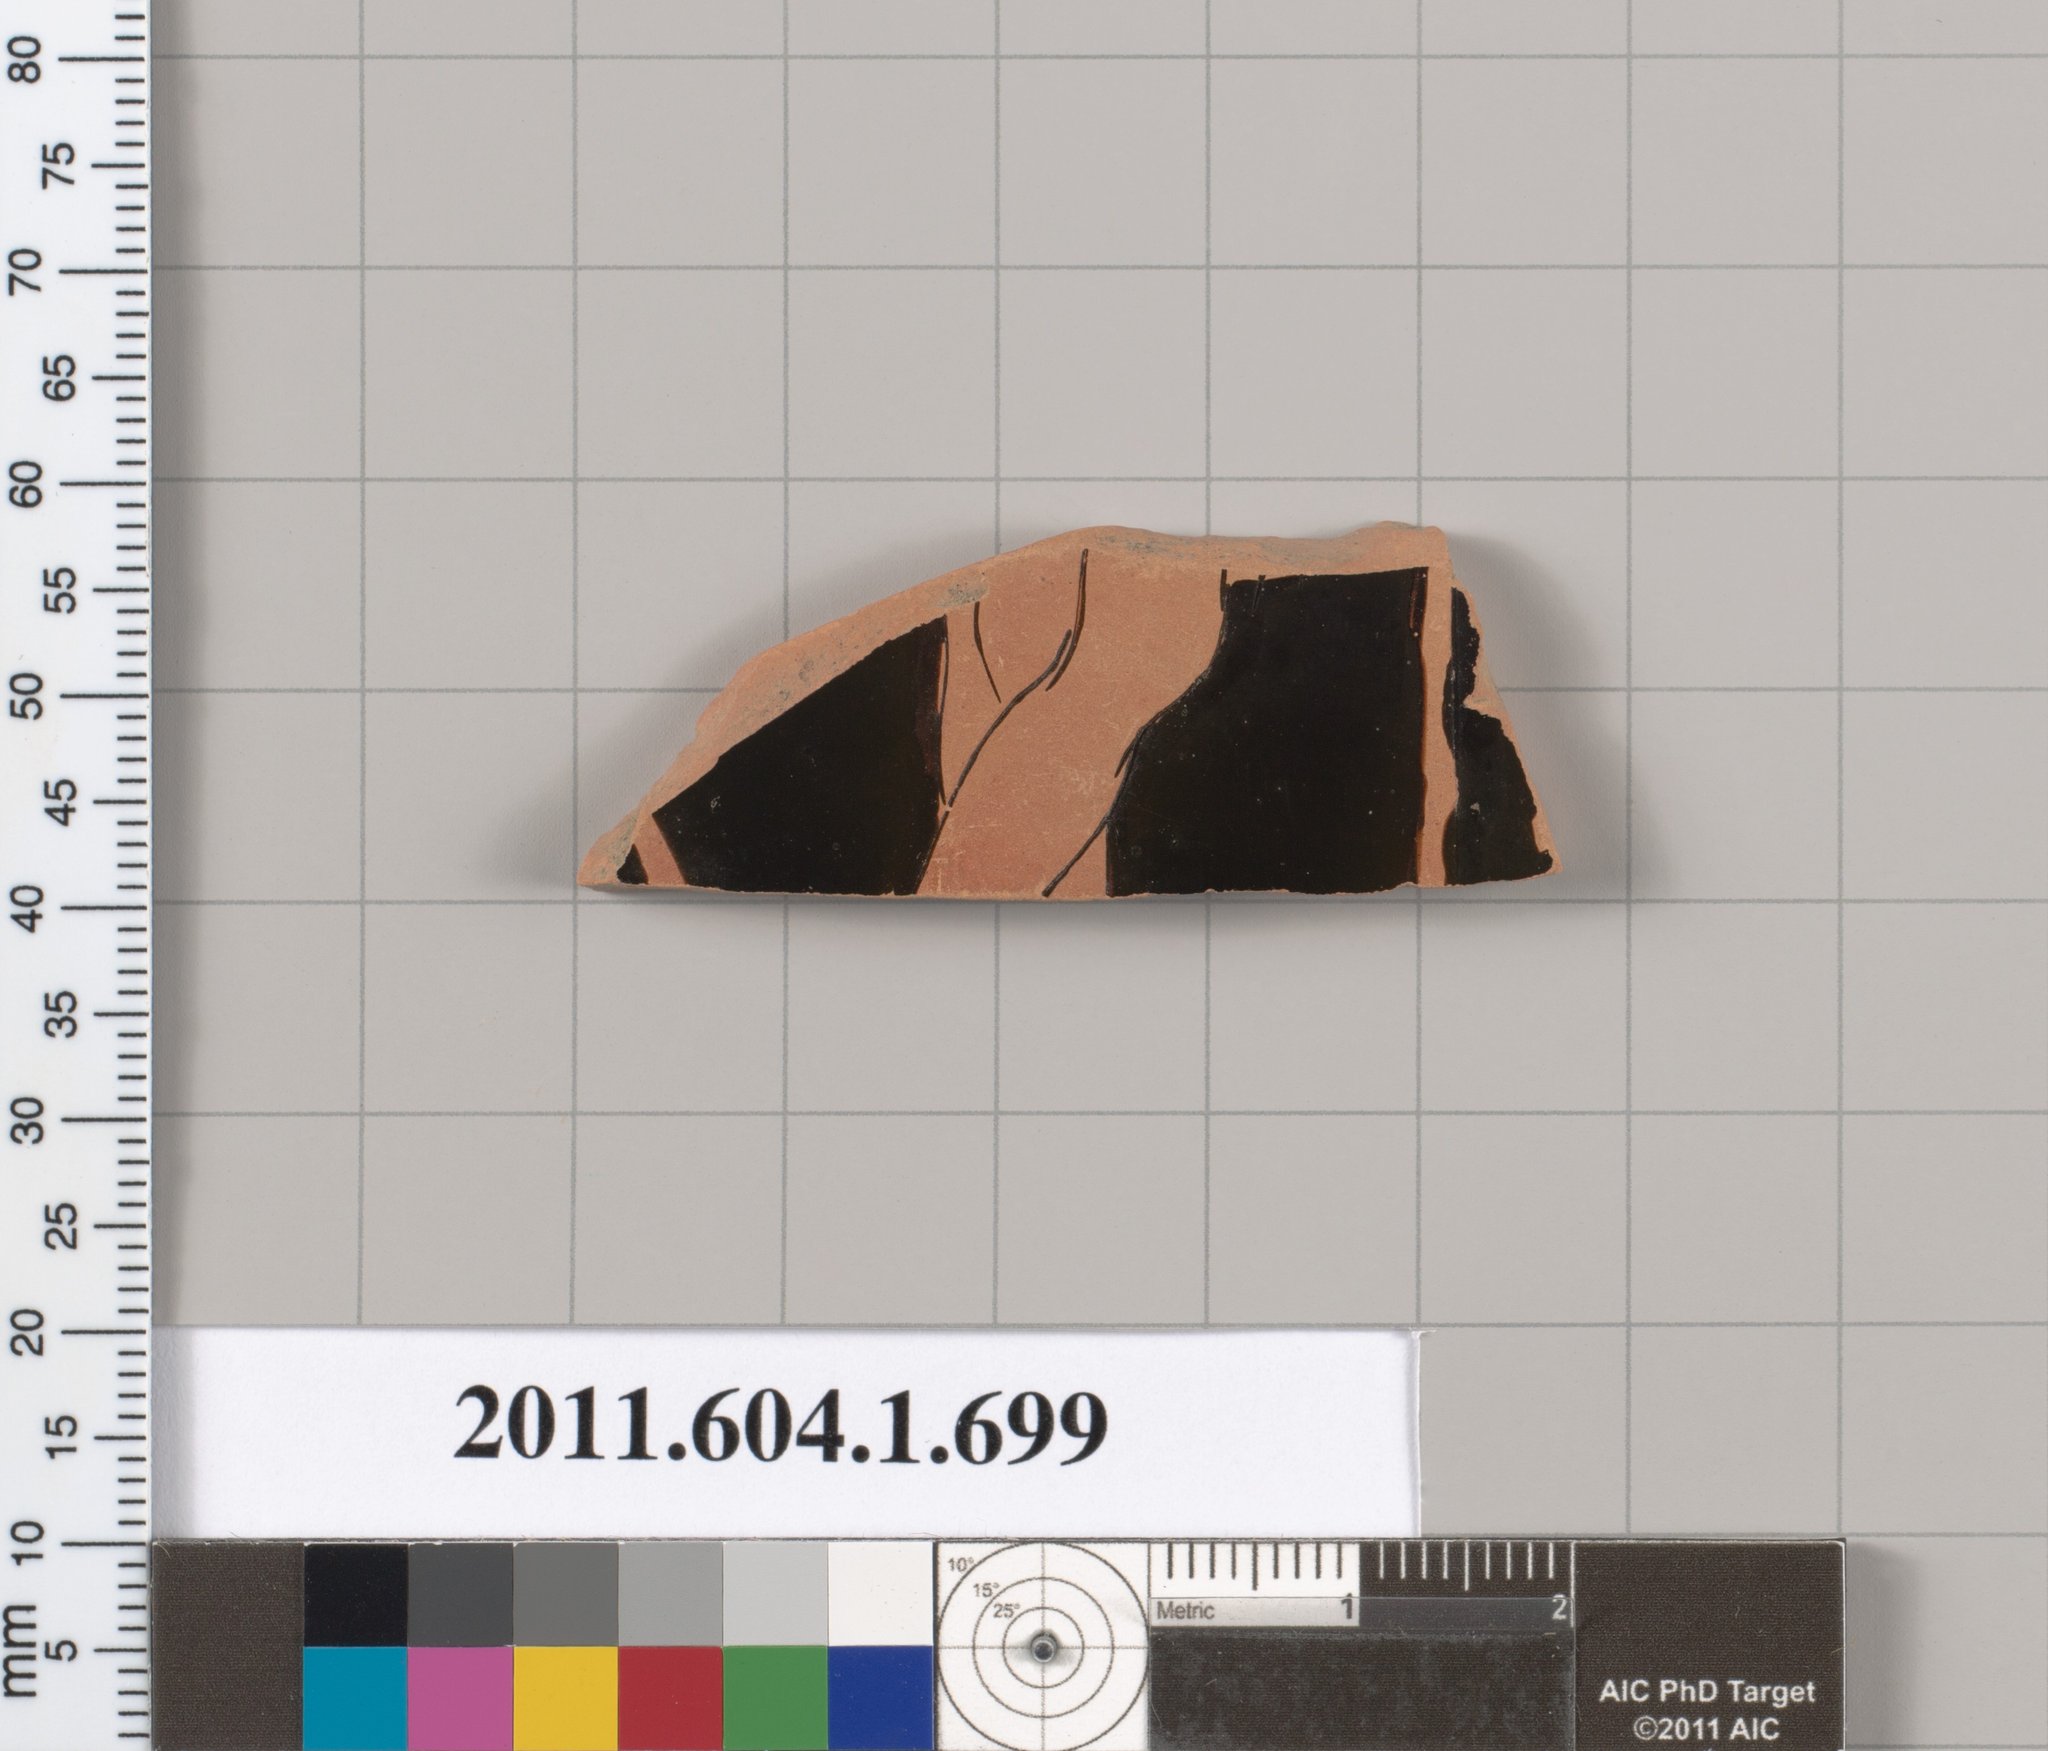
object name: kylix fragment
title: Terracotta fragment of a kylix (drinking cup)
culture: greek, attic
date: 475-451 BCE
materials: terracotta